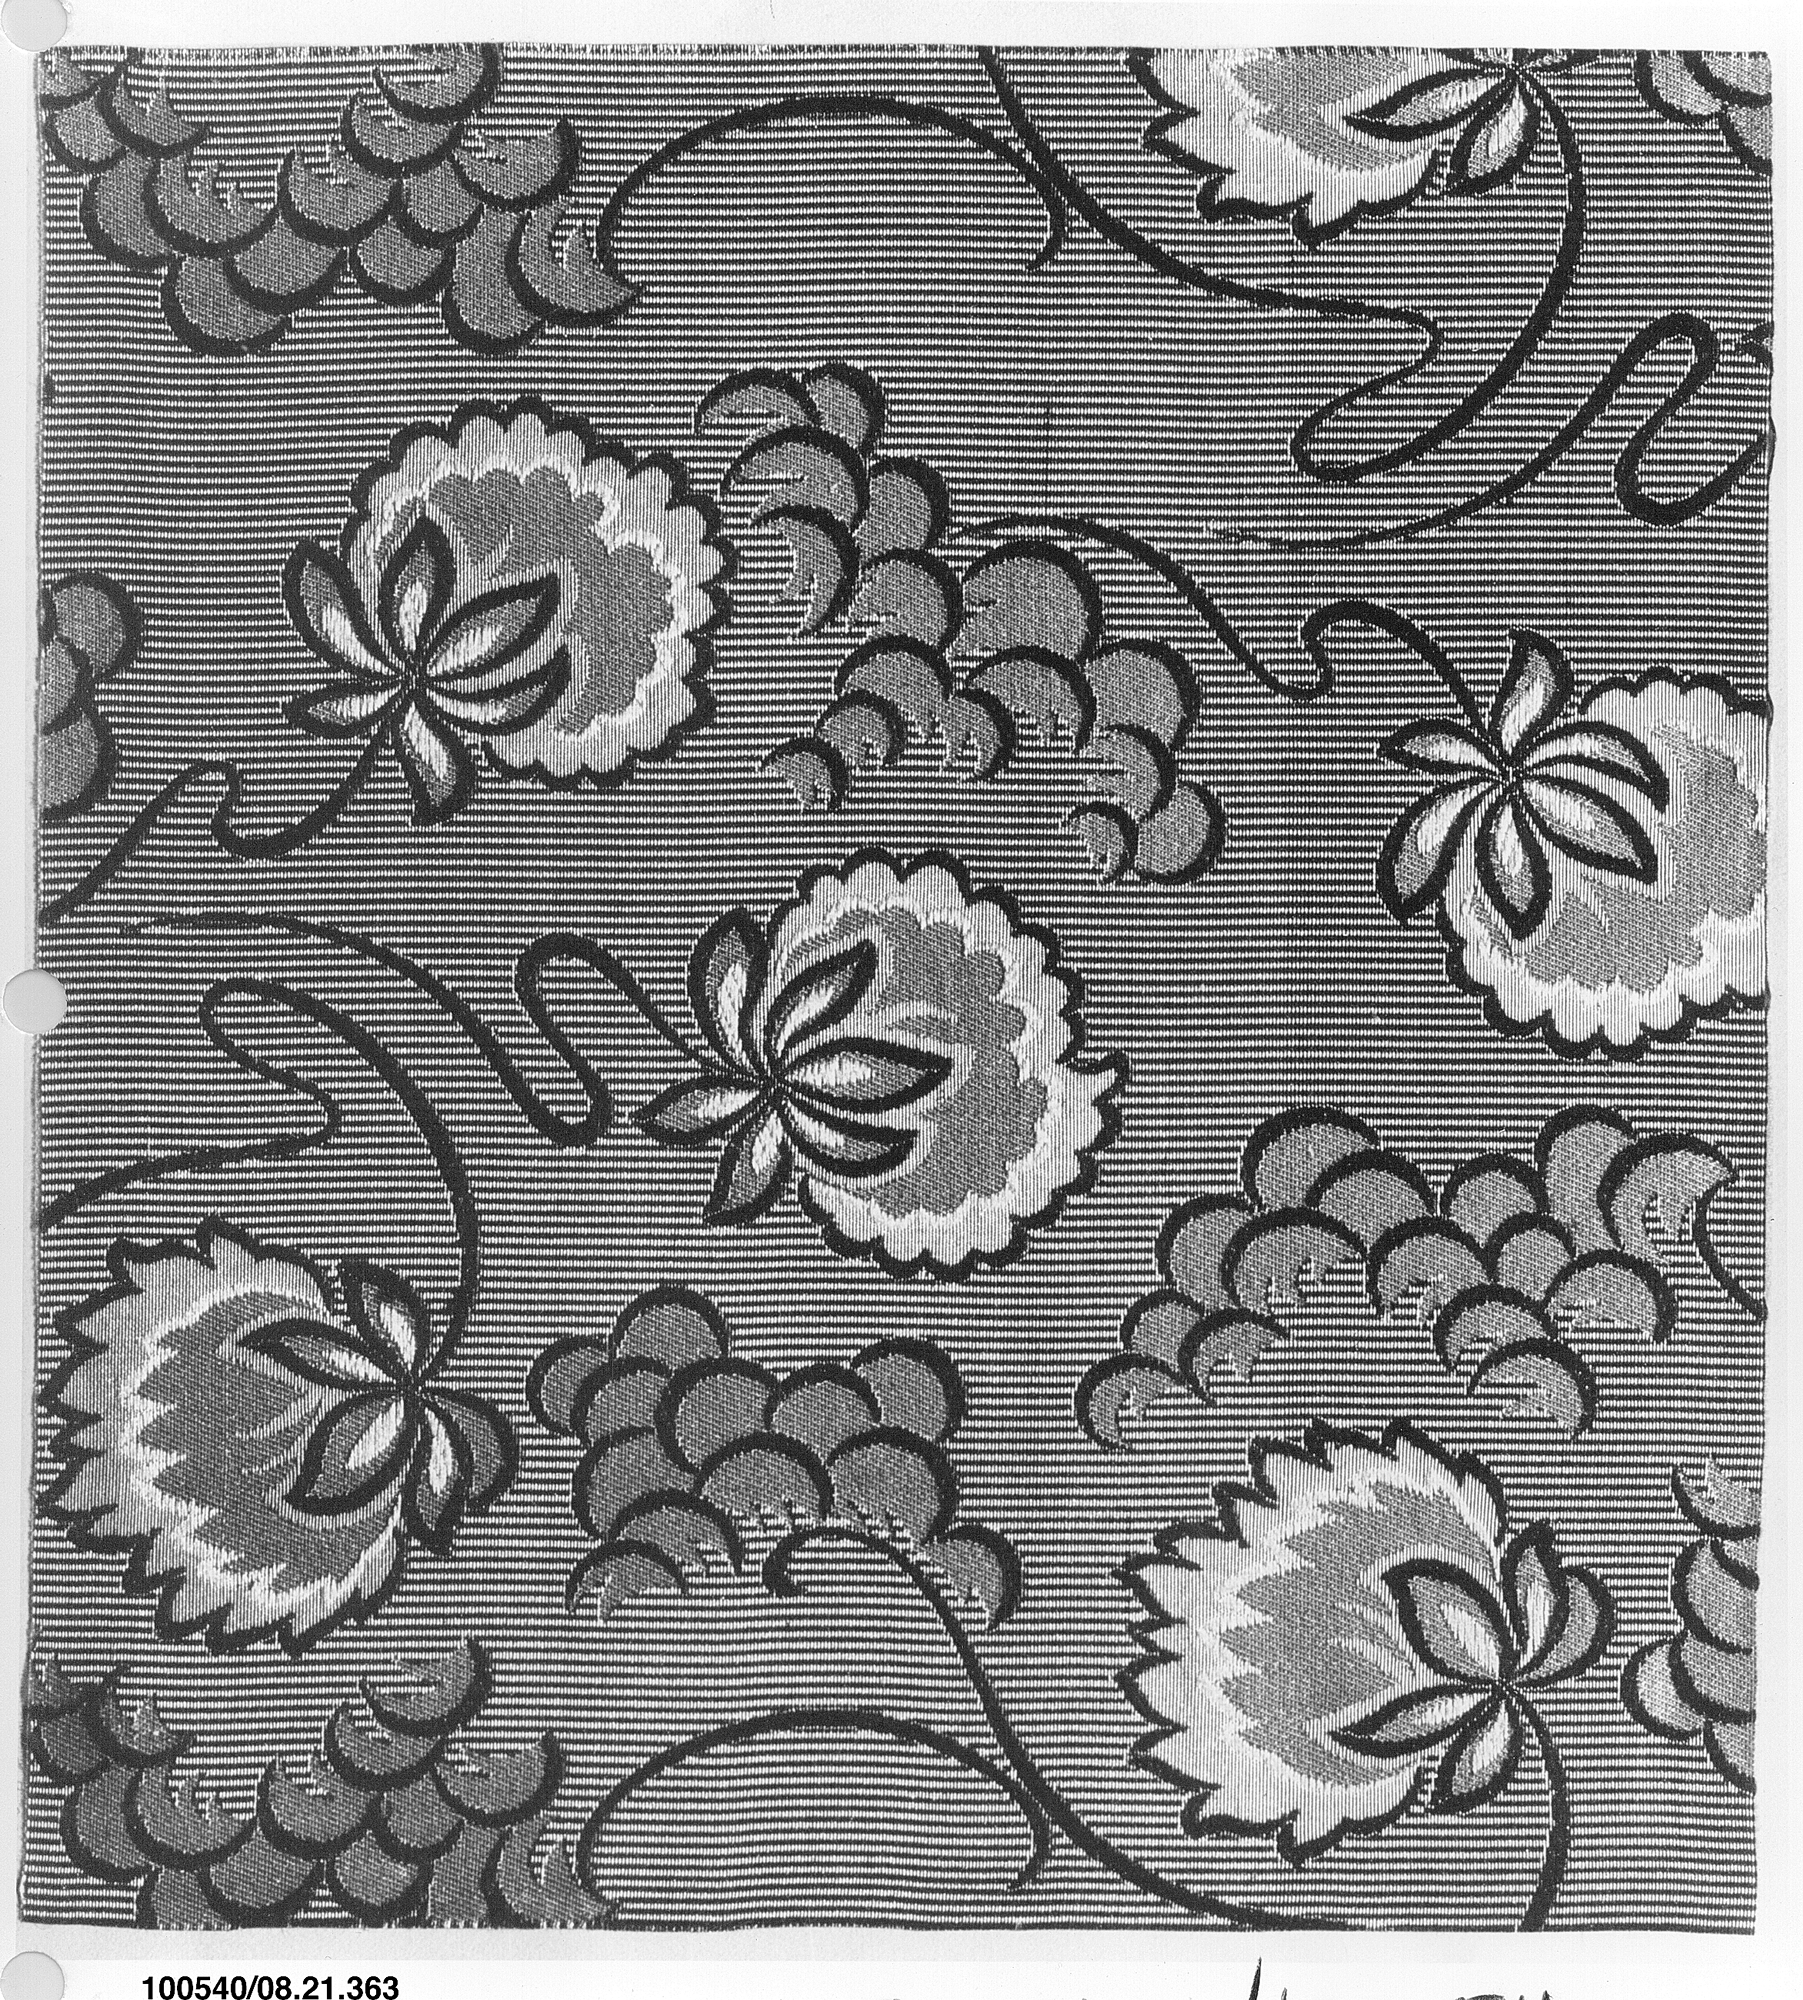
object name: textile sample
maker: Anonymous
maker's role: designer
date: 1900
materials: silk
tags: flowers